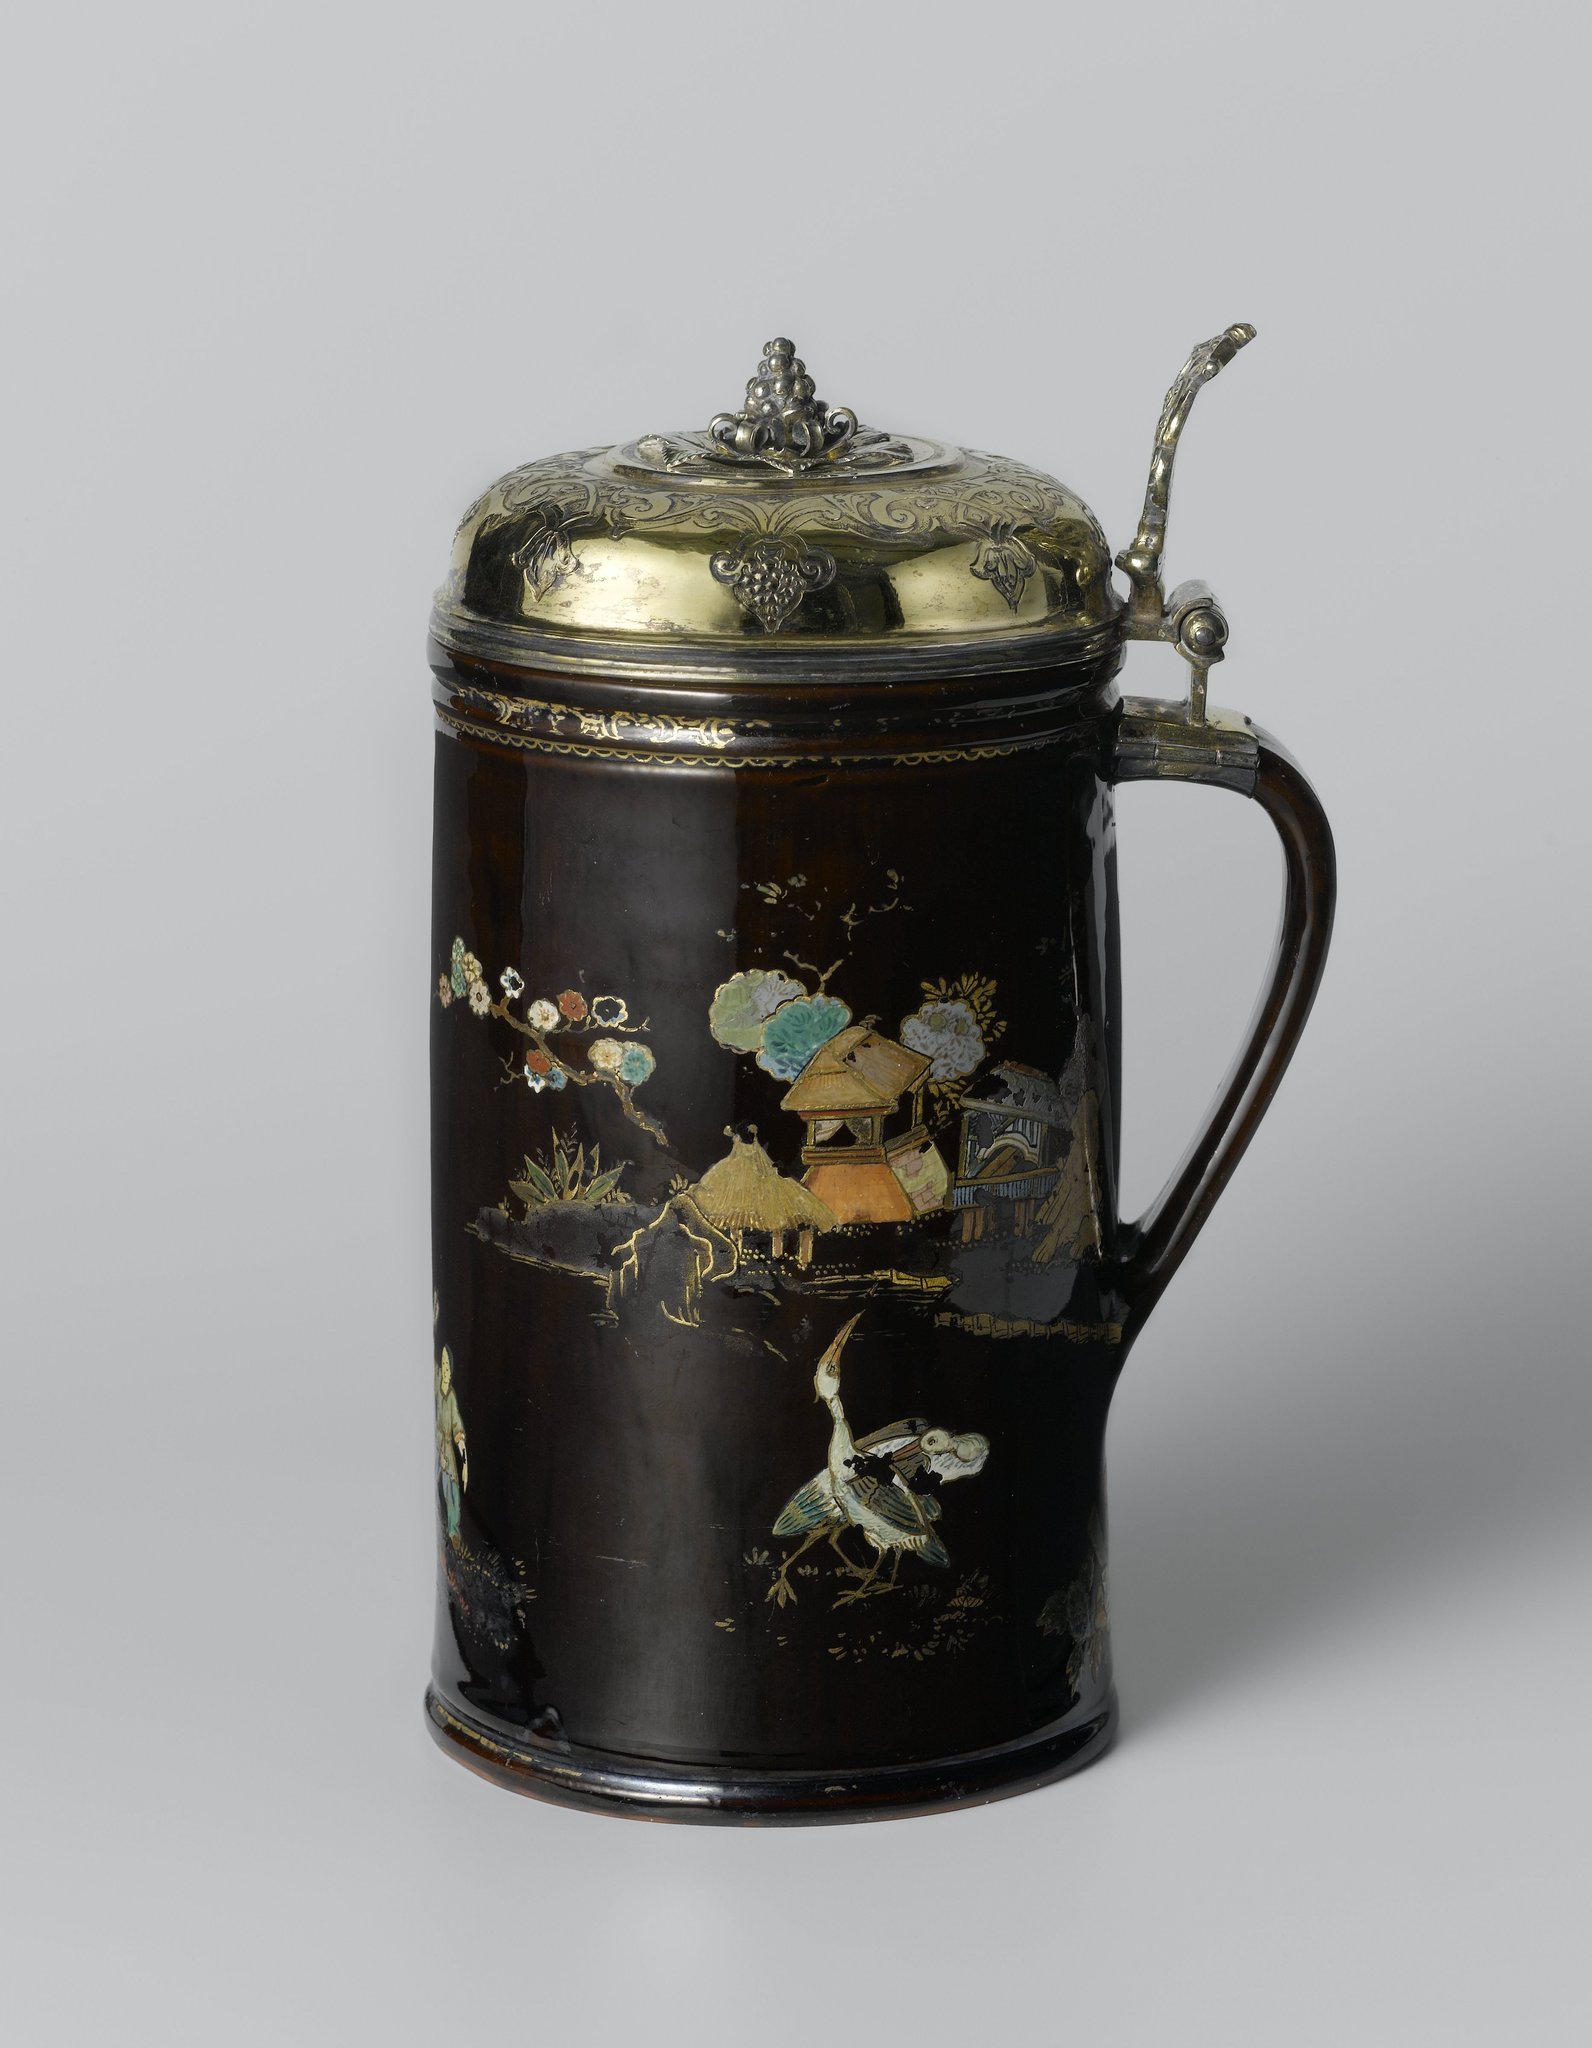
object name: stave tankard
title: Tankard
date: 1732-1733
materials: lacquer, silver, stoneware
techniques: lacquer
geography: meissen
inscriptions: town mark, maker's mark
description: Meissener Porzellan Manufaktur Meissen, c. 1715–1720 painted decoration: attributed to Martin Schnell (1675?–1740) lid: Abraham Warmberger (1670–1753), Augsburg, 1732–1733 stoneware, lacquer, silver